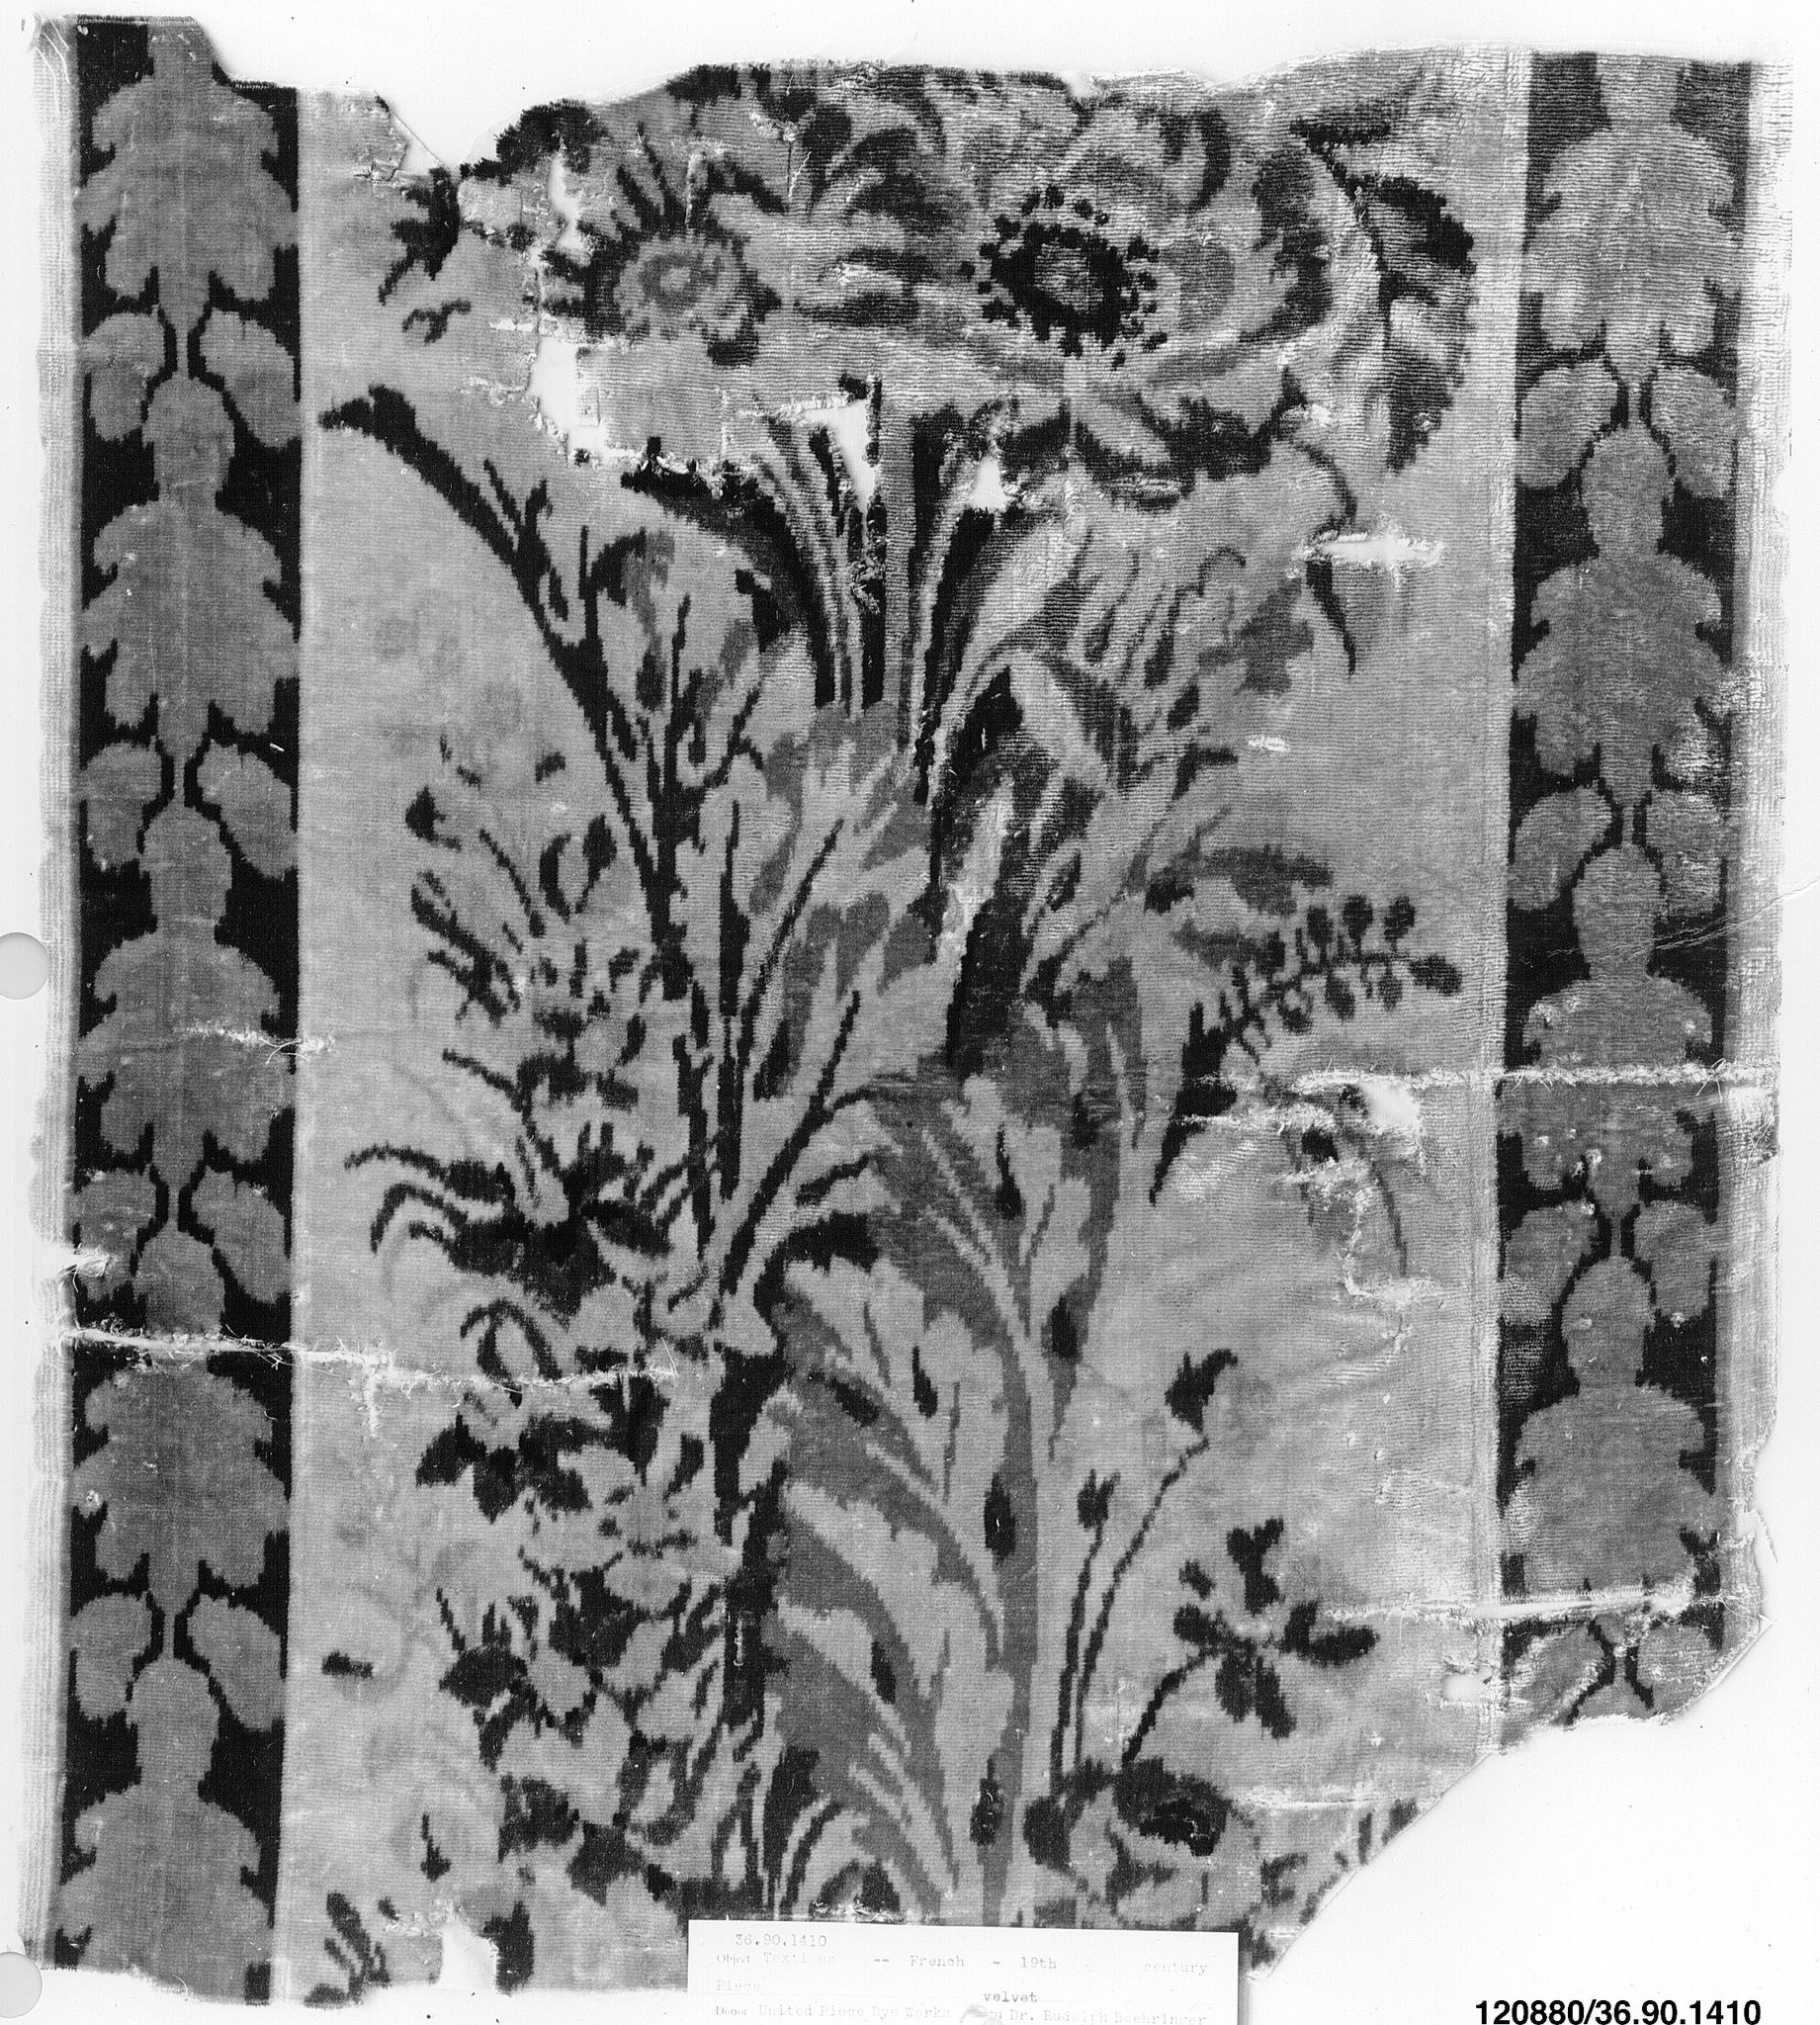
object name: piece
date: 1801-1900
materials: silk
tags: flowers,leaves